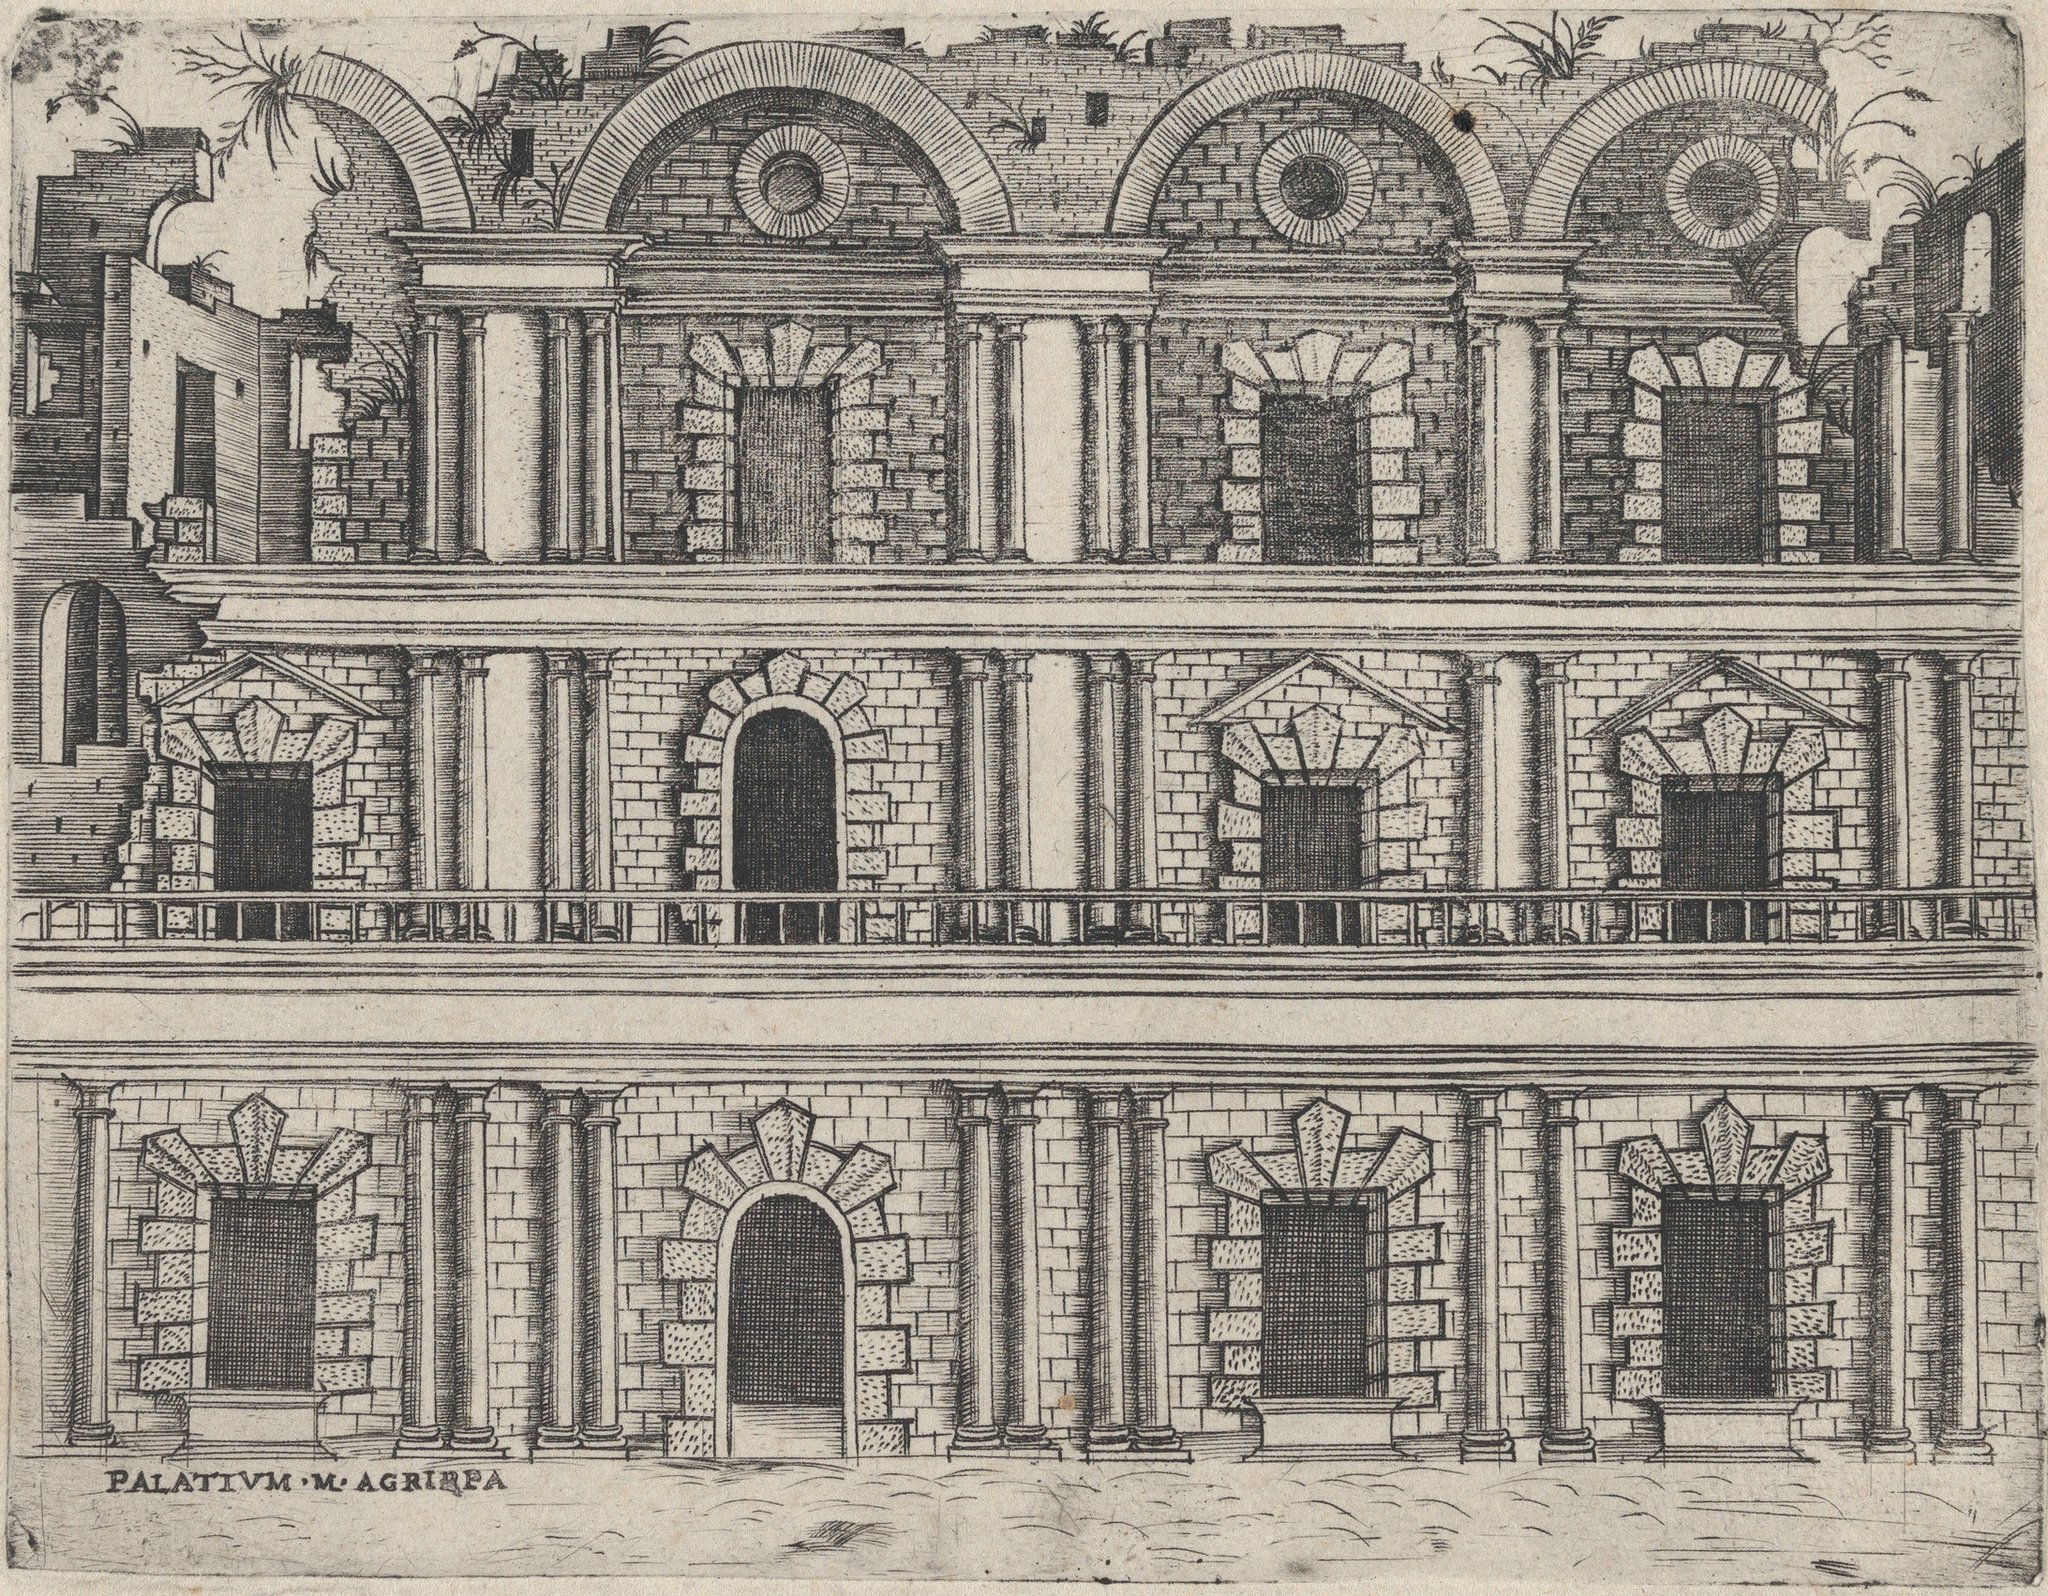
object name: print ornament architecture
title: Palatium M. Agrippa, from a Series of 24 Depicting (Reconstructed) Buildings from Roman Antiquity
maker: anonymous, italian, 16th century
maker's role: artist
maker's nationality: italian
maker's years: 1500-1600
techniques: engraving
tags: architecture,buildings